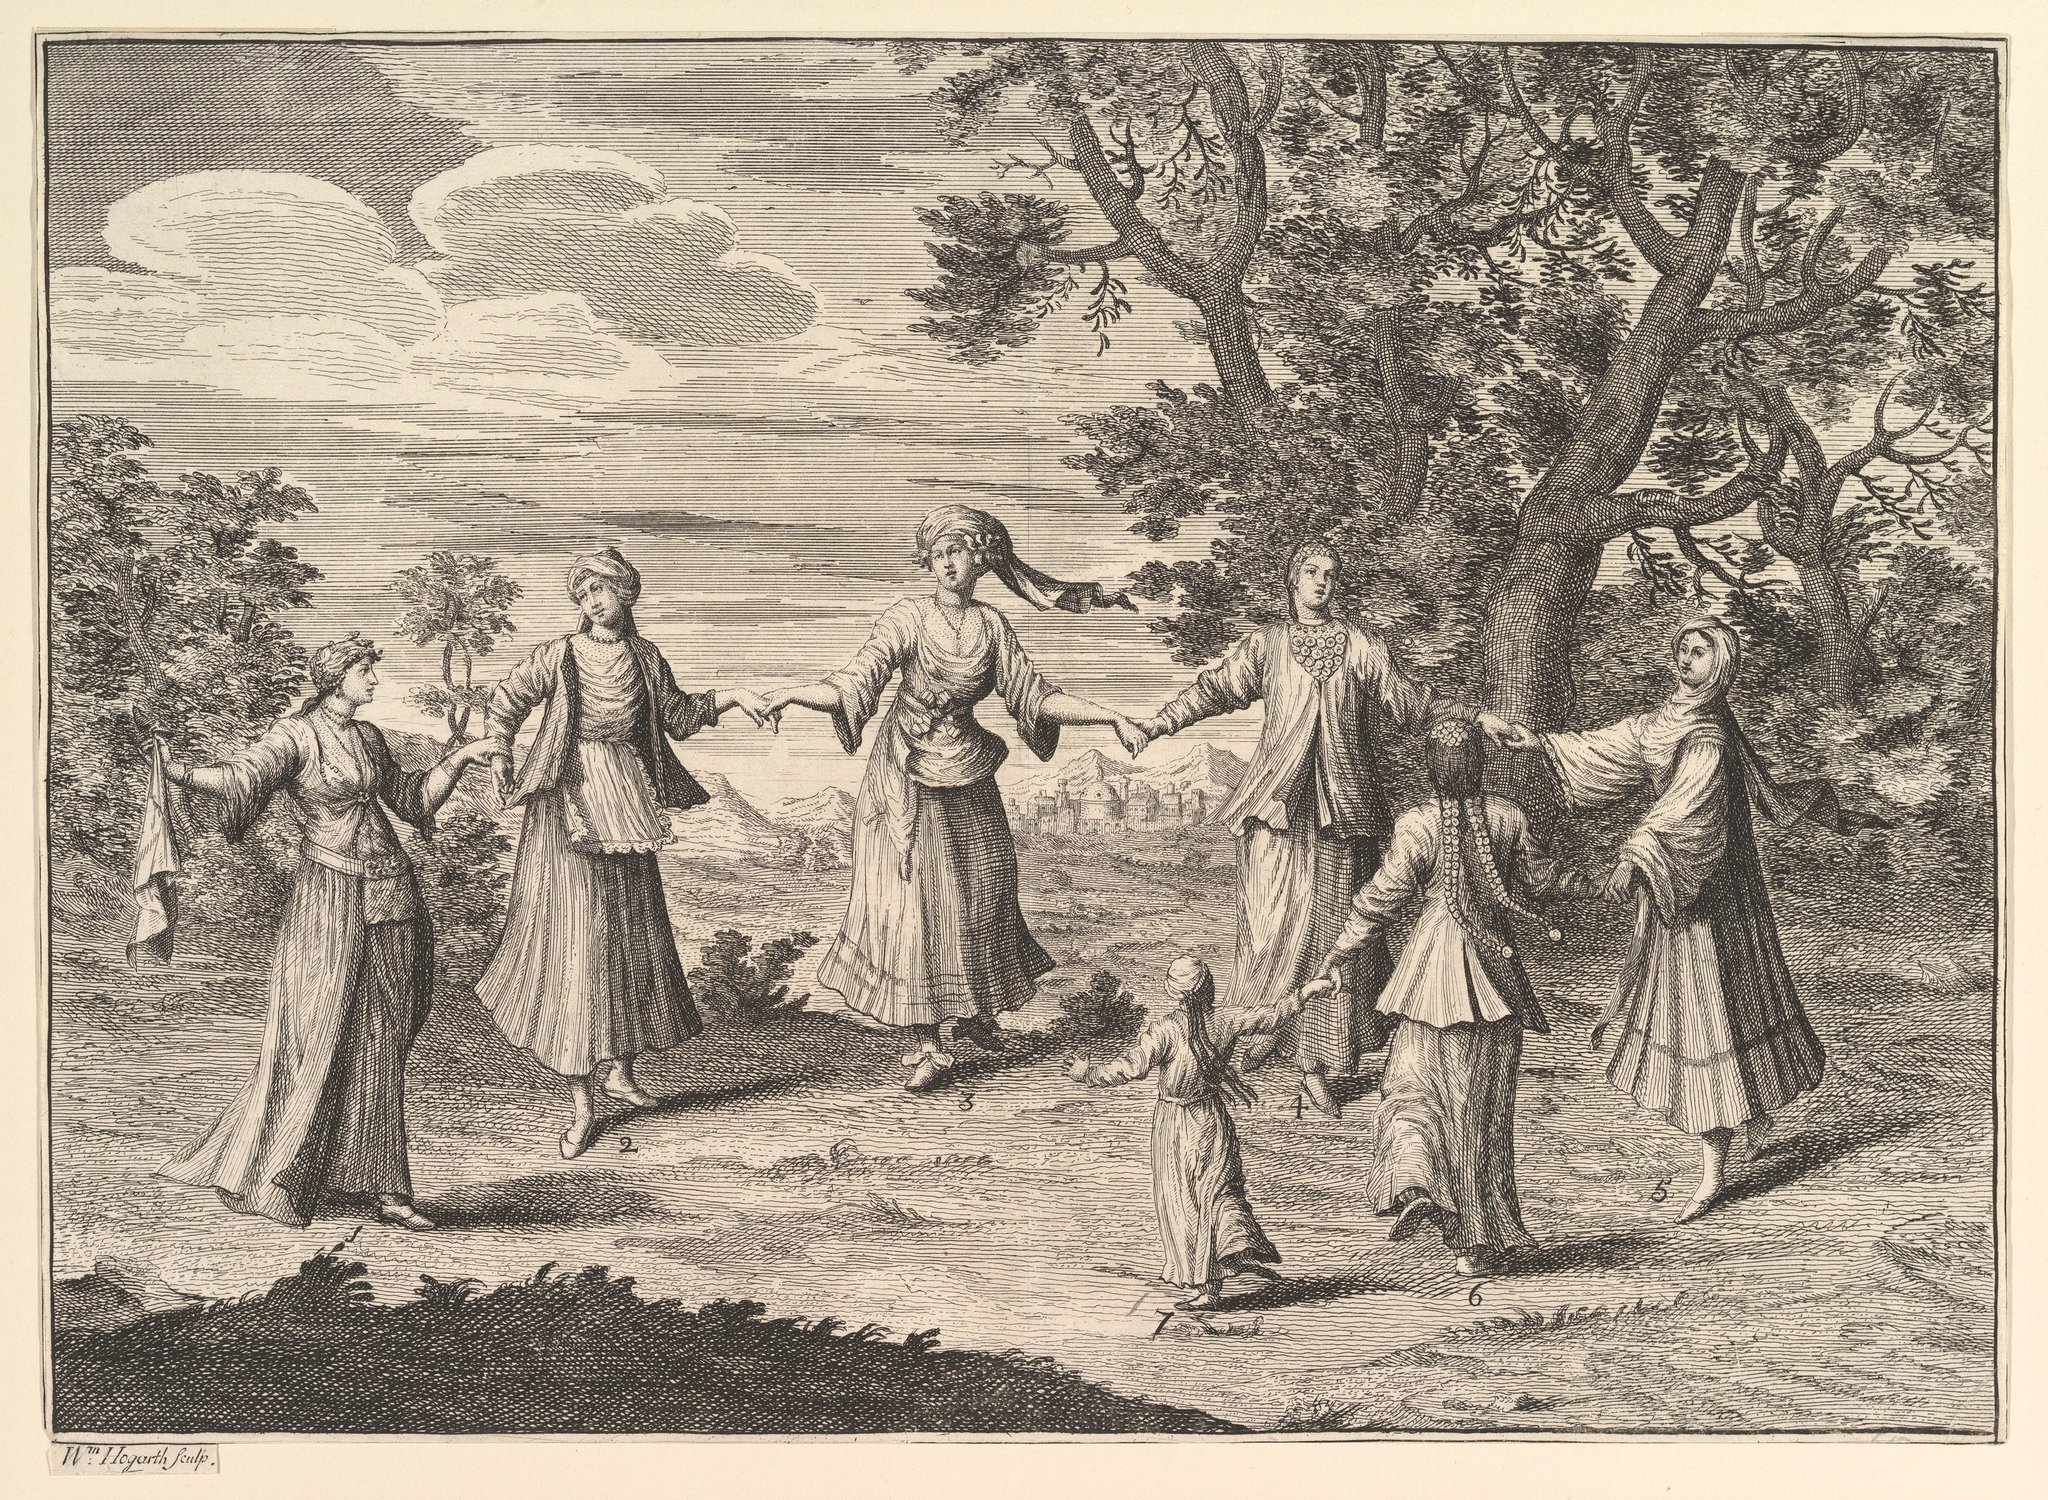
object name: print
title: A Native Dance (Aubry de La Mottraye's "Travels throughout Europe, Asia and into Part of Africa...," London, 1724, vol. I, pl. 11)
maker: william hogarth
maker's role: artist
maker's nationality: british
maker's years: 1697-1764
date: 1723-1724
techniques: engraving, etching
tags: dance,girls,women